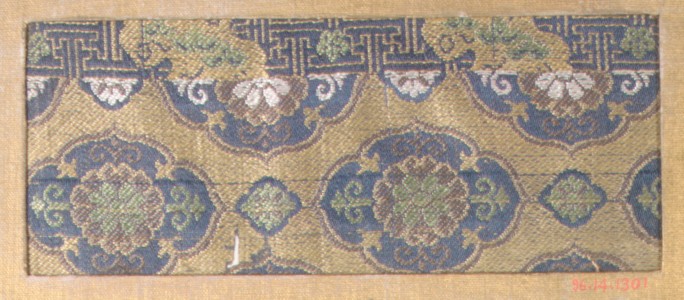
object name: piece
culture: japanese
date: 1701-1900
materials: silk